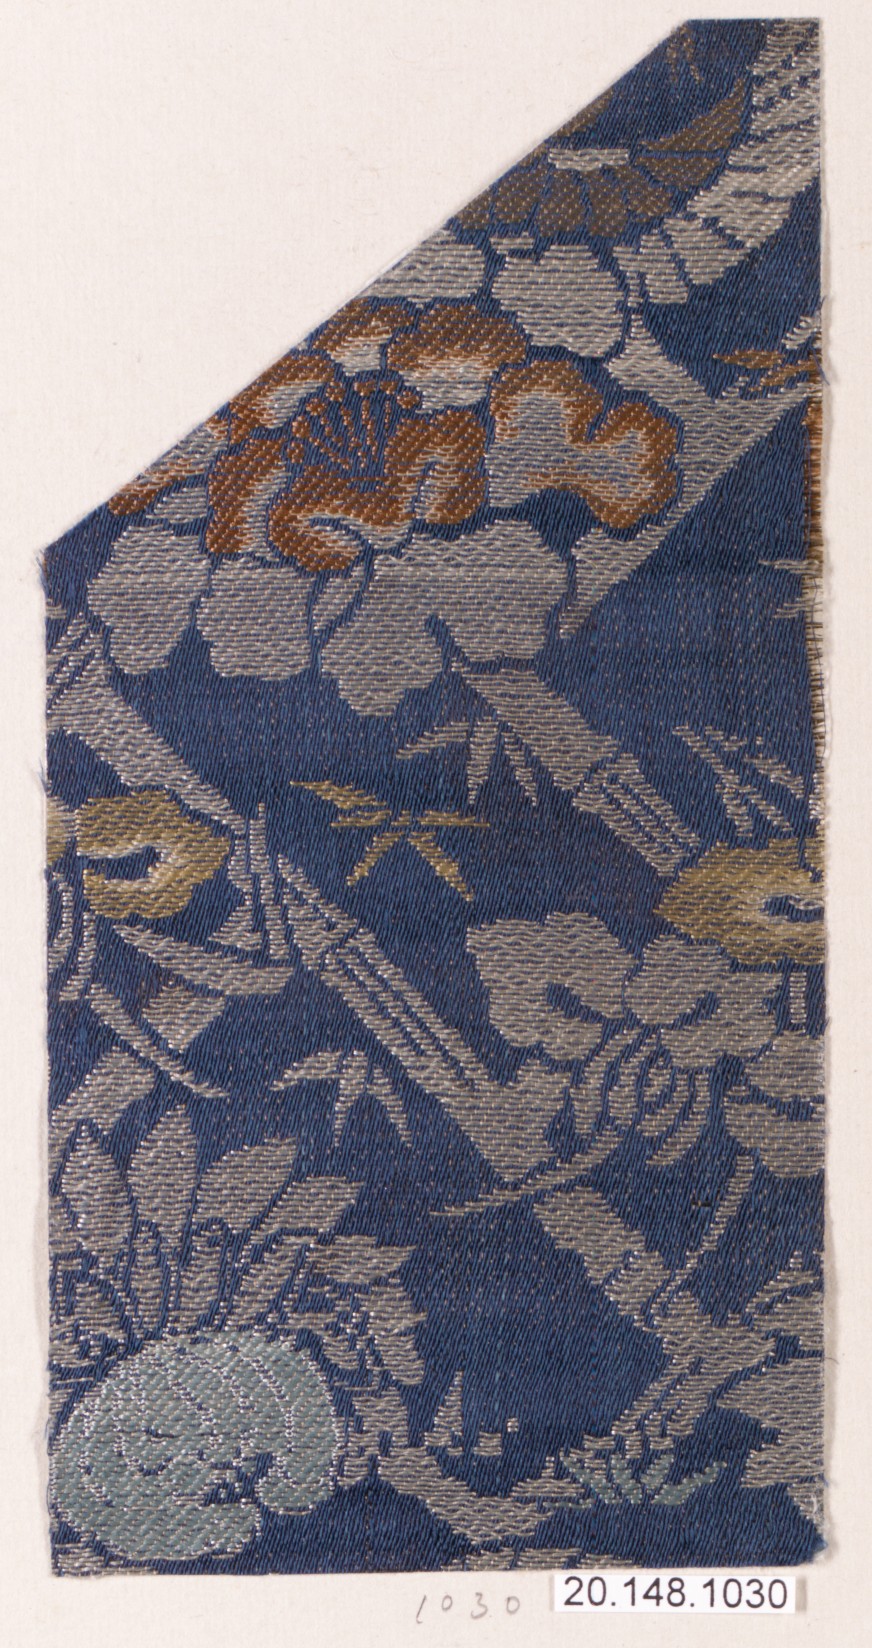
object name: piece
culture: japanese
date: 1701-1800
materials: silk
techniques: compound weave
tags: flowers